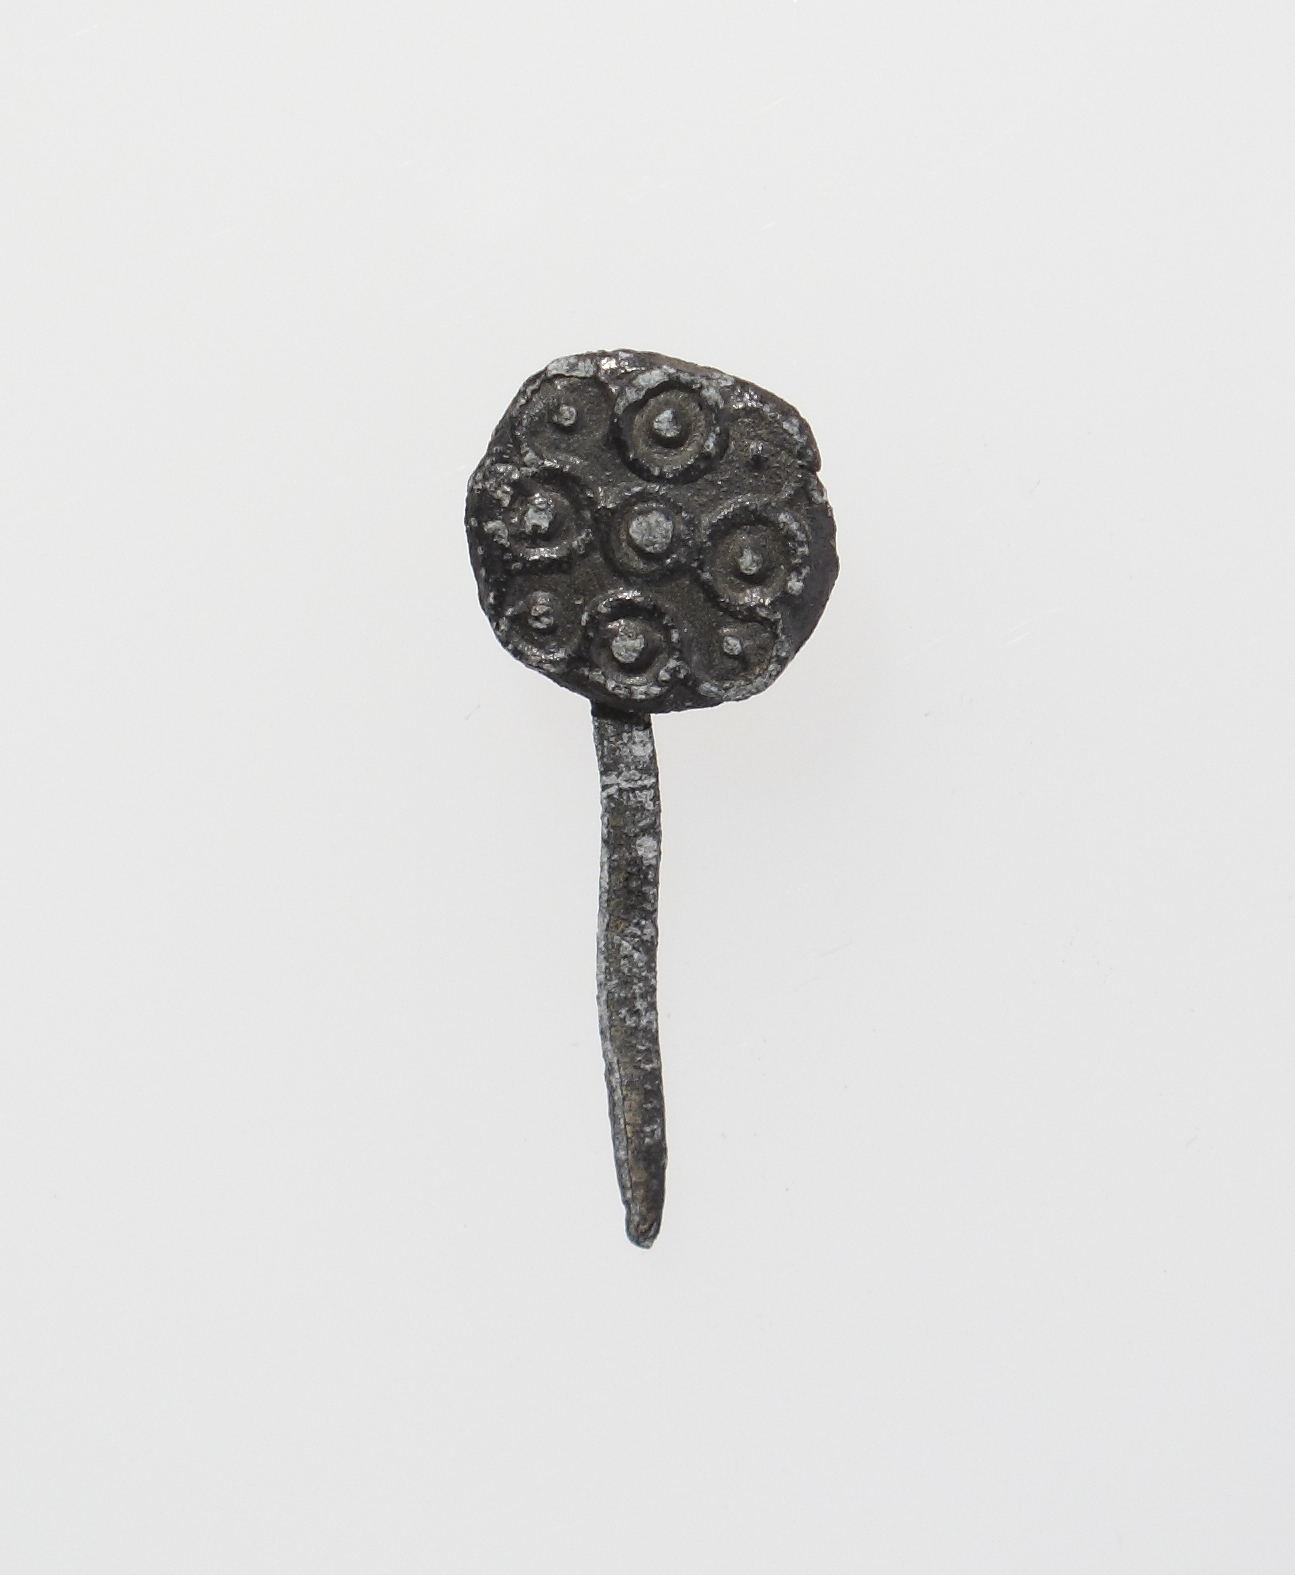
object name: pilgrim's badge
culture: french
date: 1301-1600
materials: lead